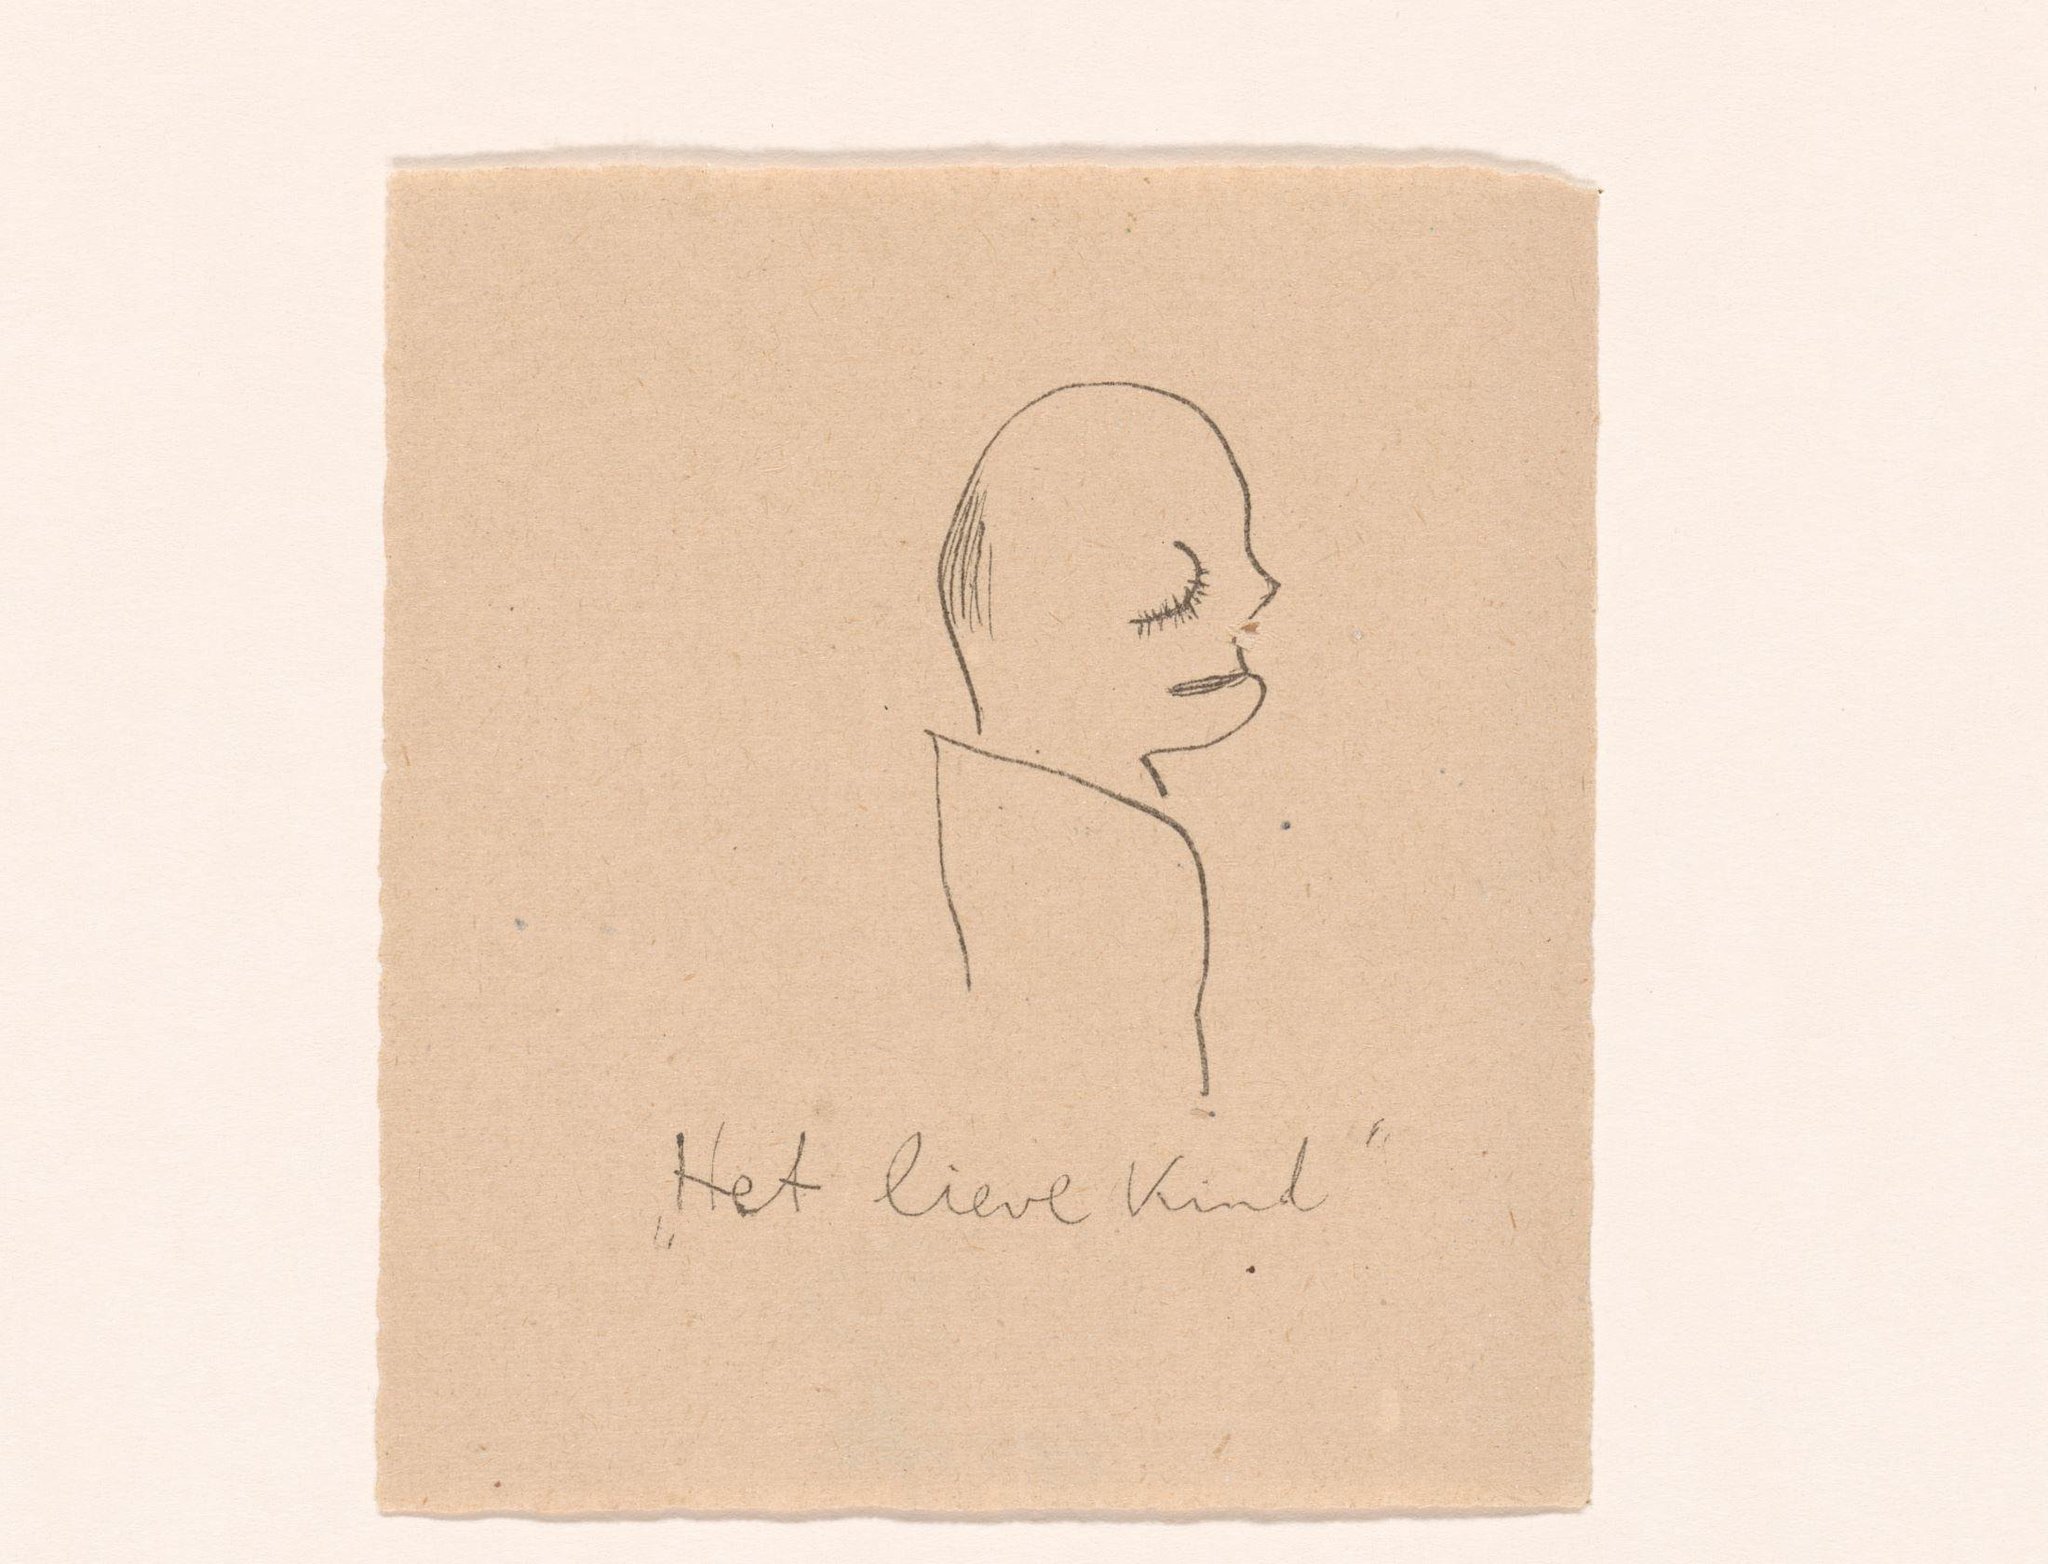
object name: print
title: Idealisten II en verdere Kanttekeningen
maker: erich wichmann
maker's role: print maker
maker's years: 1890-1929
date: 1923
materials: paper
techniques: lithograph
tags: caricatures (human types), child between toddler and youth (of undetermined sex)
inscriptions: collector's mark: Lugt 2228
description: Een figuur met een kaal hoofd en gesloten ogen.